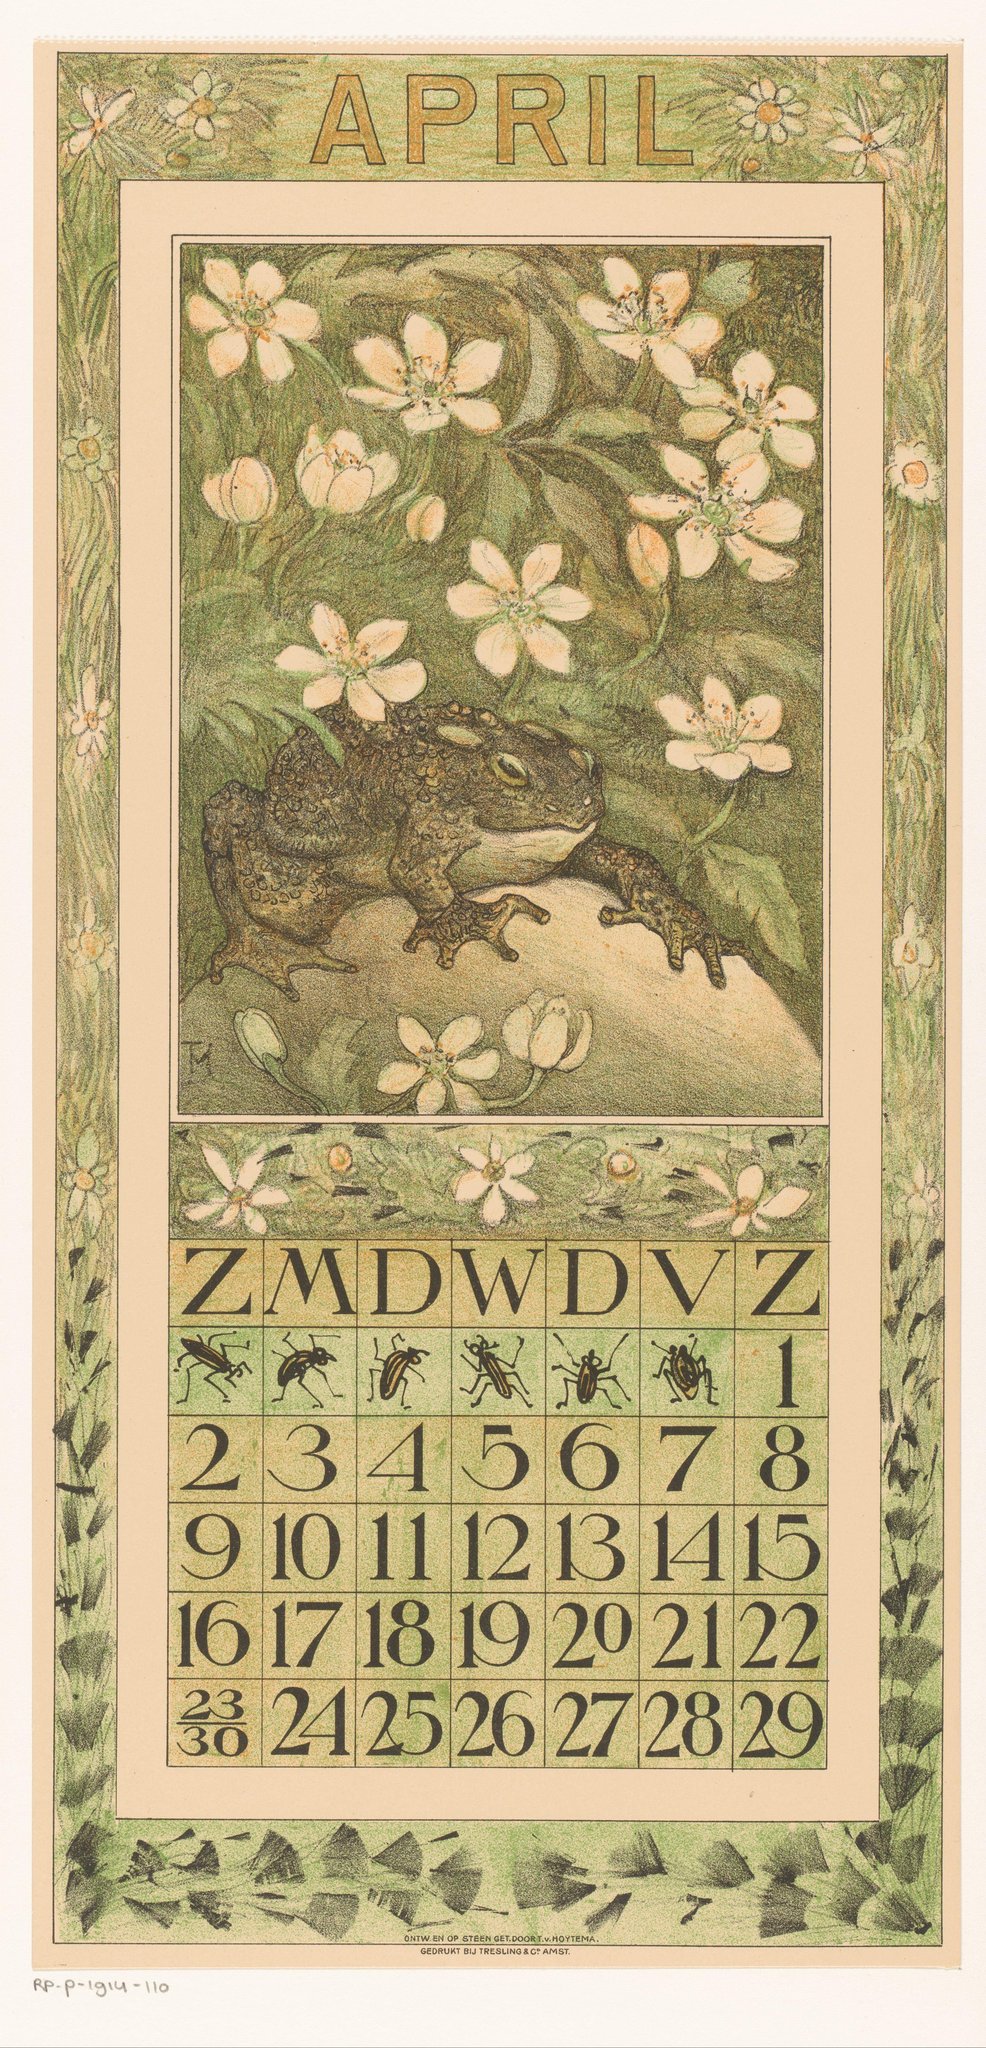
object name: print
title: Pad onder bloesems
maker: theo van hoytema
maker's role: draughtsman, painter, print maker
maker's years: 1863-1917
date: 1910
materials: paper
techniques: lithograph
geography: amsterdam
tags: tailless amphibians: frog, tailless amphibians: toad, april ~ other concepts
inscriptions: collector's mark: Lugt 2228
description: De kikker zit op een steen onder bloesem. In de ornamentrand bloemen. In het calendarium kevers. Bovenaan het blad een scheurlijn.